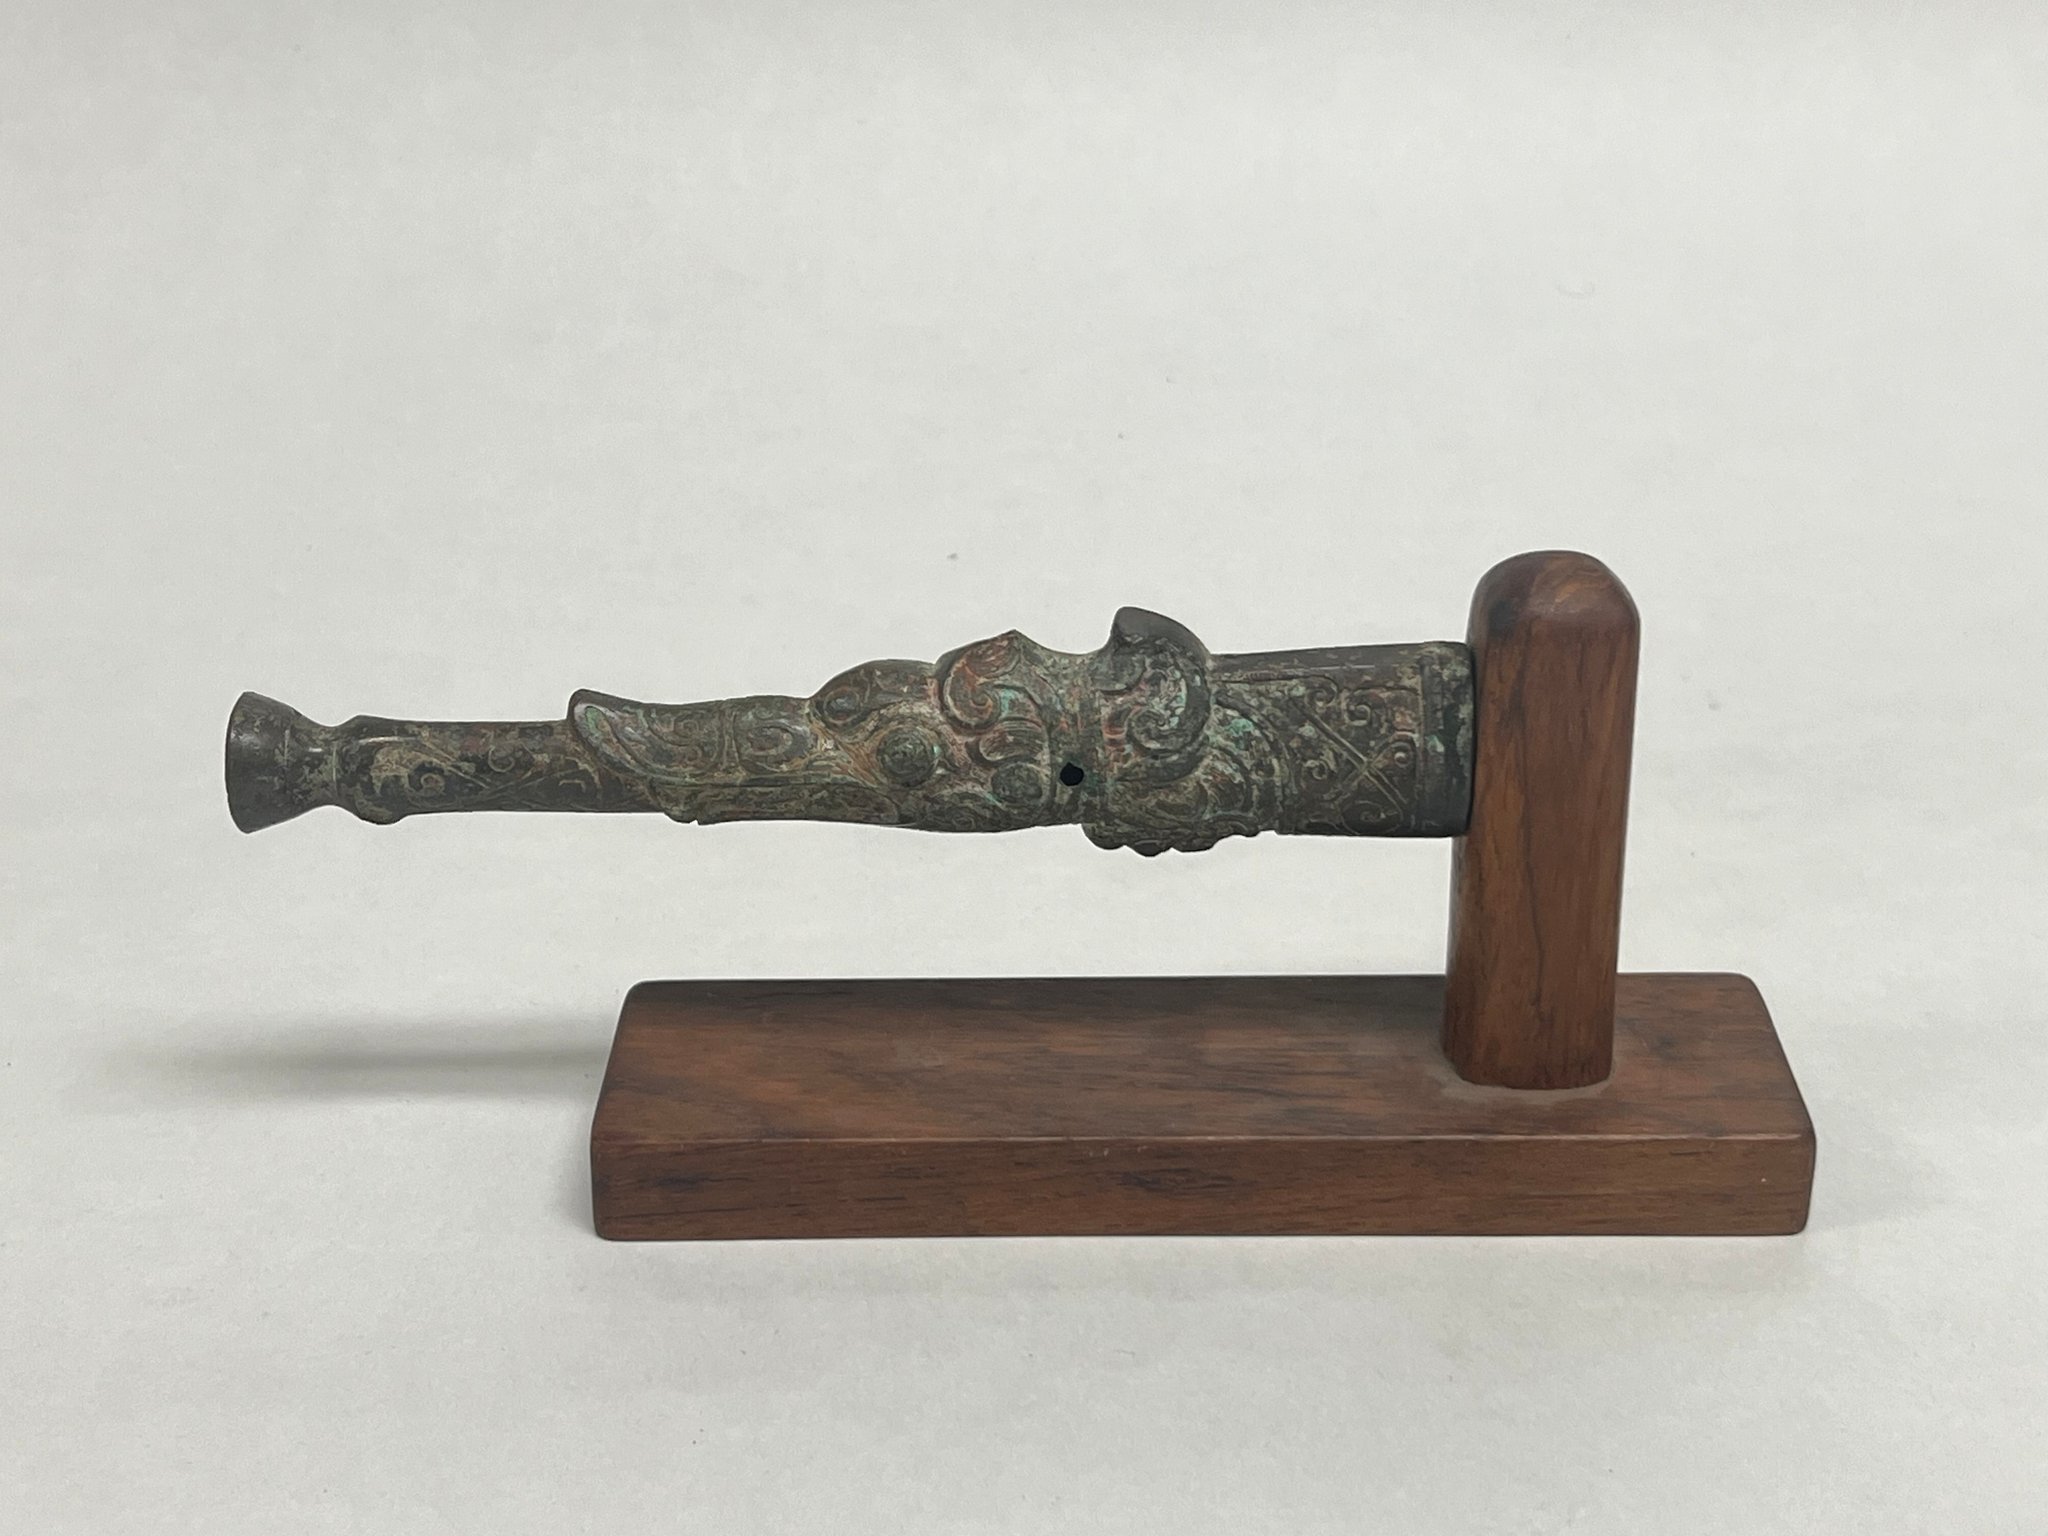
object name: ferrule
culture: chinese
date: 500-301 BCE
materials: bronze